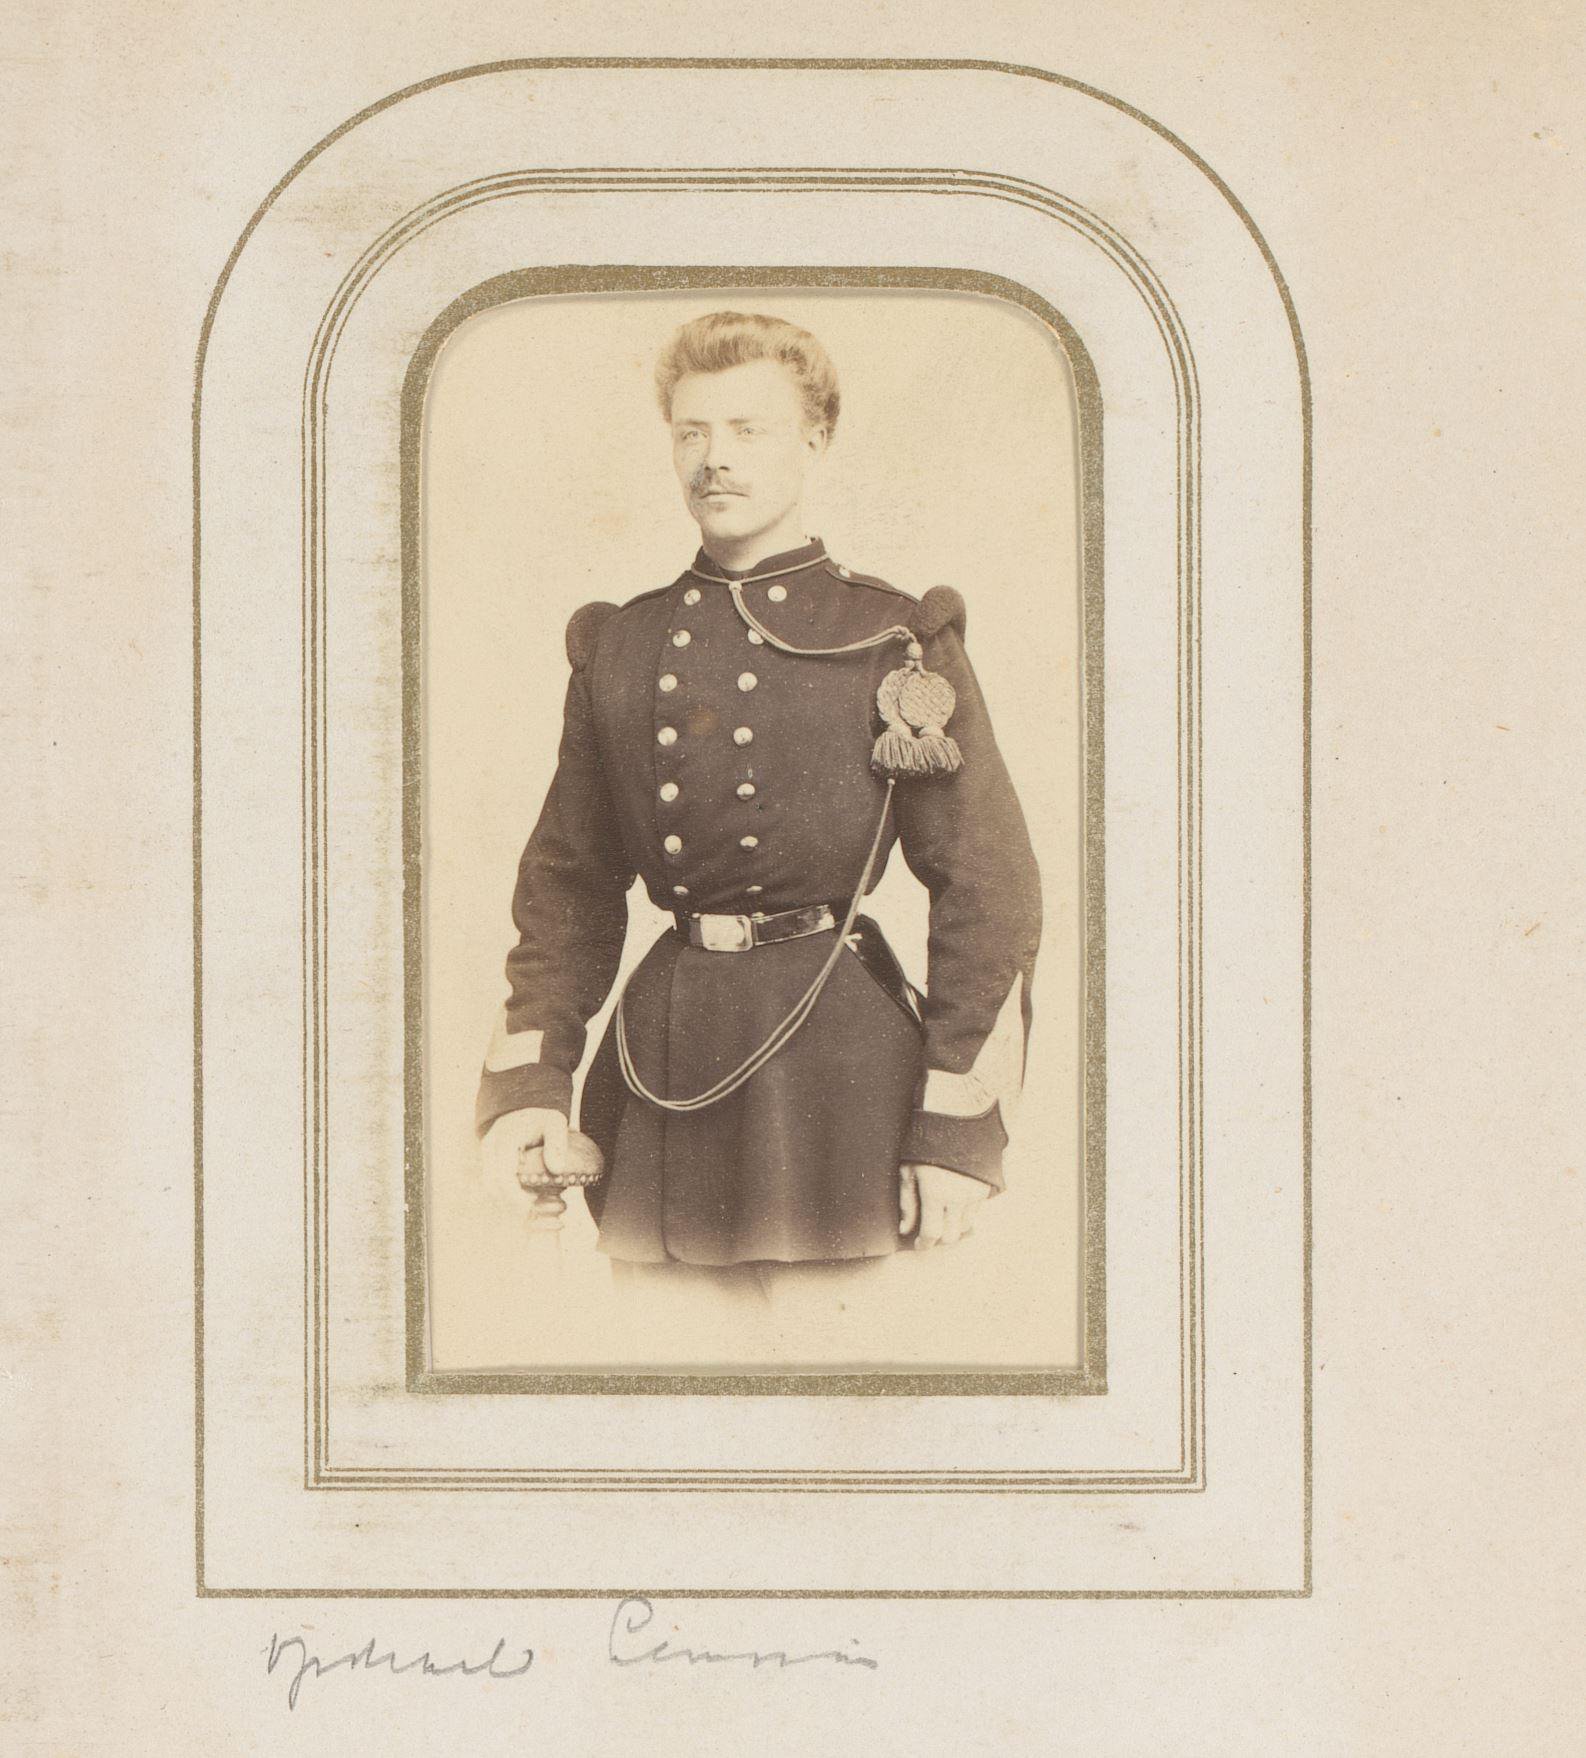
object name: album leaf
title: Portret van een staande man met snor in uniform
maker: albert delabarre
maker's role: musician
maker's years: 1809-1885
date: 1866-1884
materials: cardboard, photographic support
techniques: albumen print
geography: brussels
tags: moustache, historical persons, (military) uniforms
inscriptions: annotation: ‘opdracht Lemoine’, annotation: ‘A Monsieur le capitaine/ et [...] Major Lemoine/ les carabiniers/ comme:/ marque de ma reconnaissance/ [...] gage de mon/ [dévouement à toutes épreuves le sergent major ...]’, inscription: ‘Photographie Parisienne/ 36, Rue Fossé aux Loups, 36/ (Place de la Monnaie)/ Bruxelles’